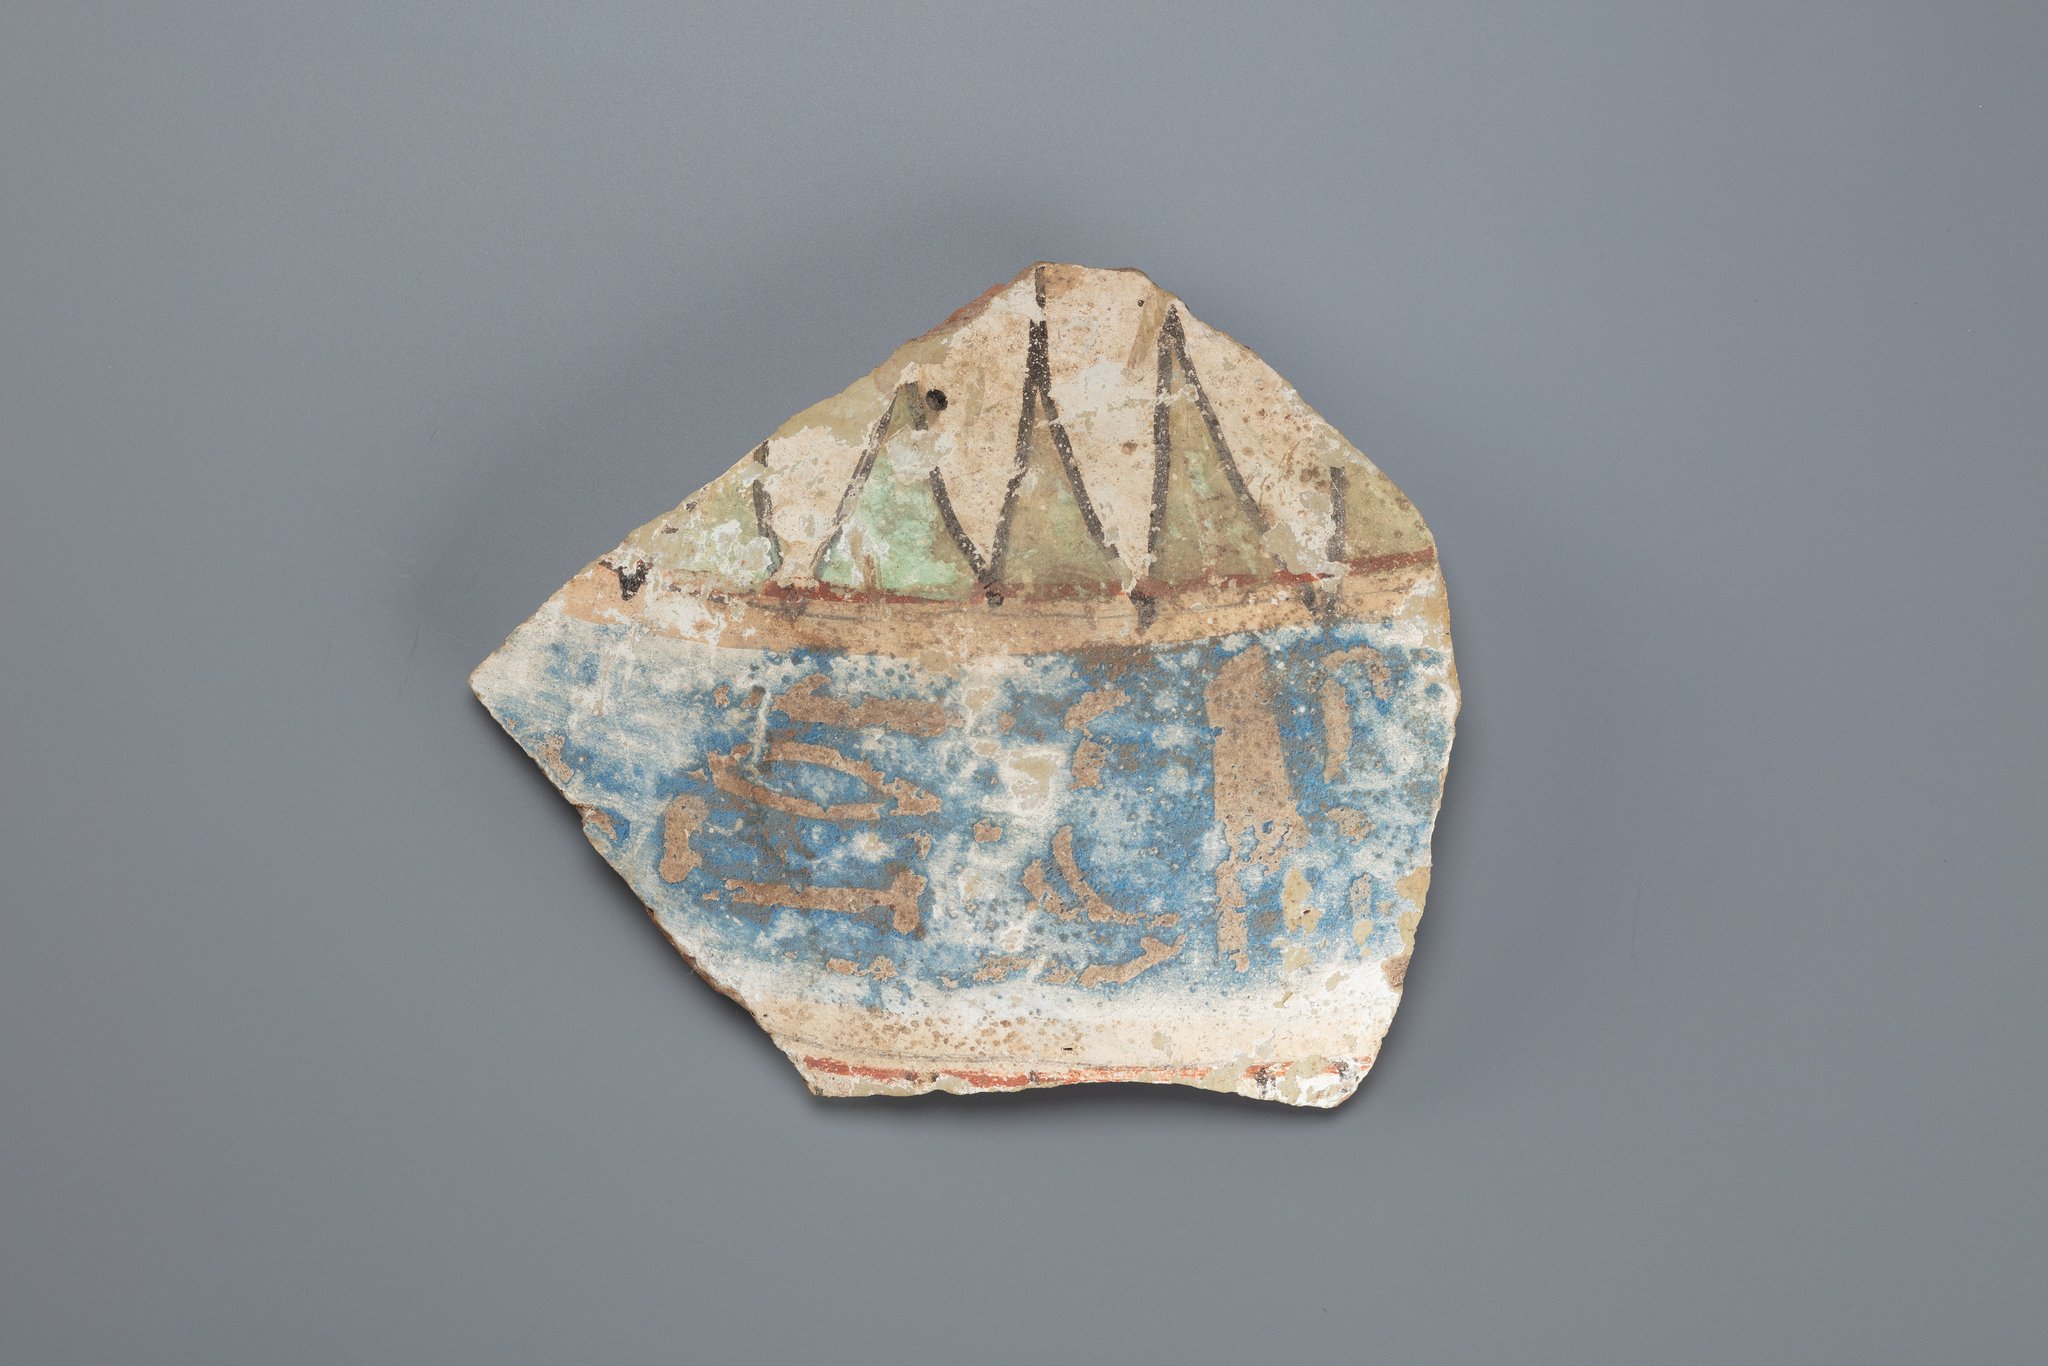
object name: jar fragment, inscribed, malqata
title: Decorated jar fragment with inscription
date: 1390-1352 BCE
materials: ink, paint, pottery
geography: egypt